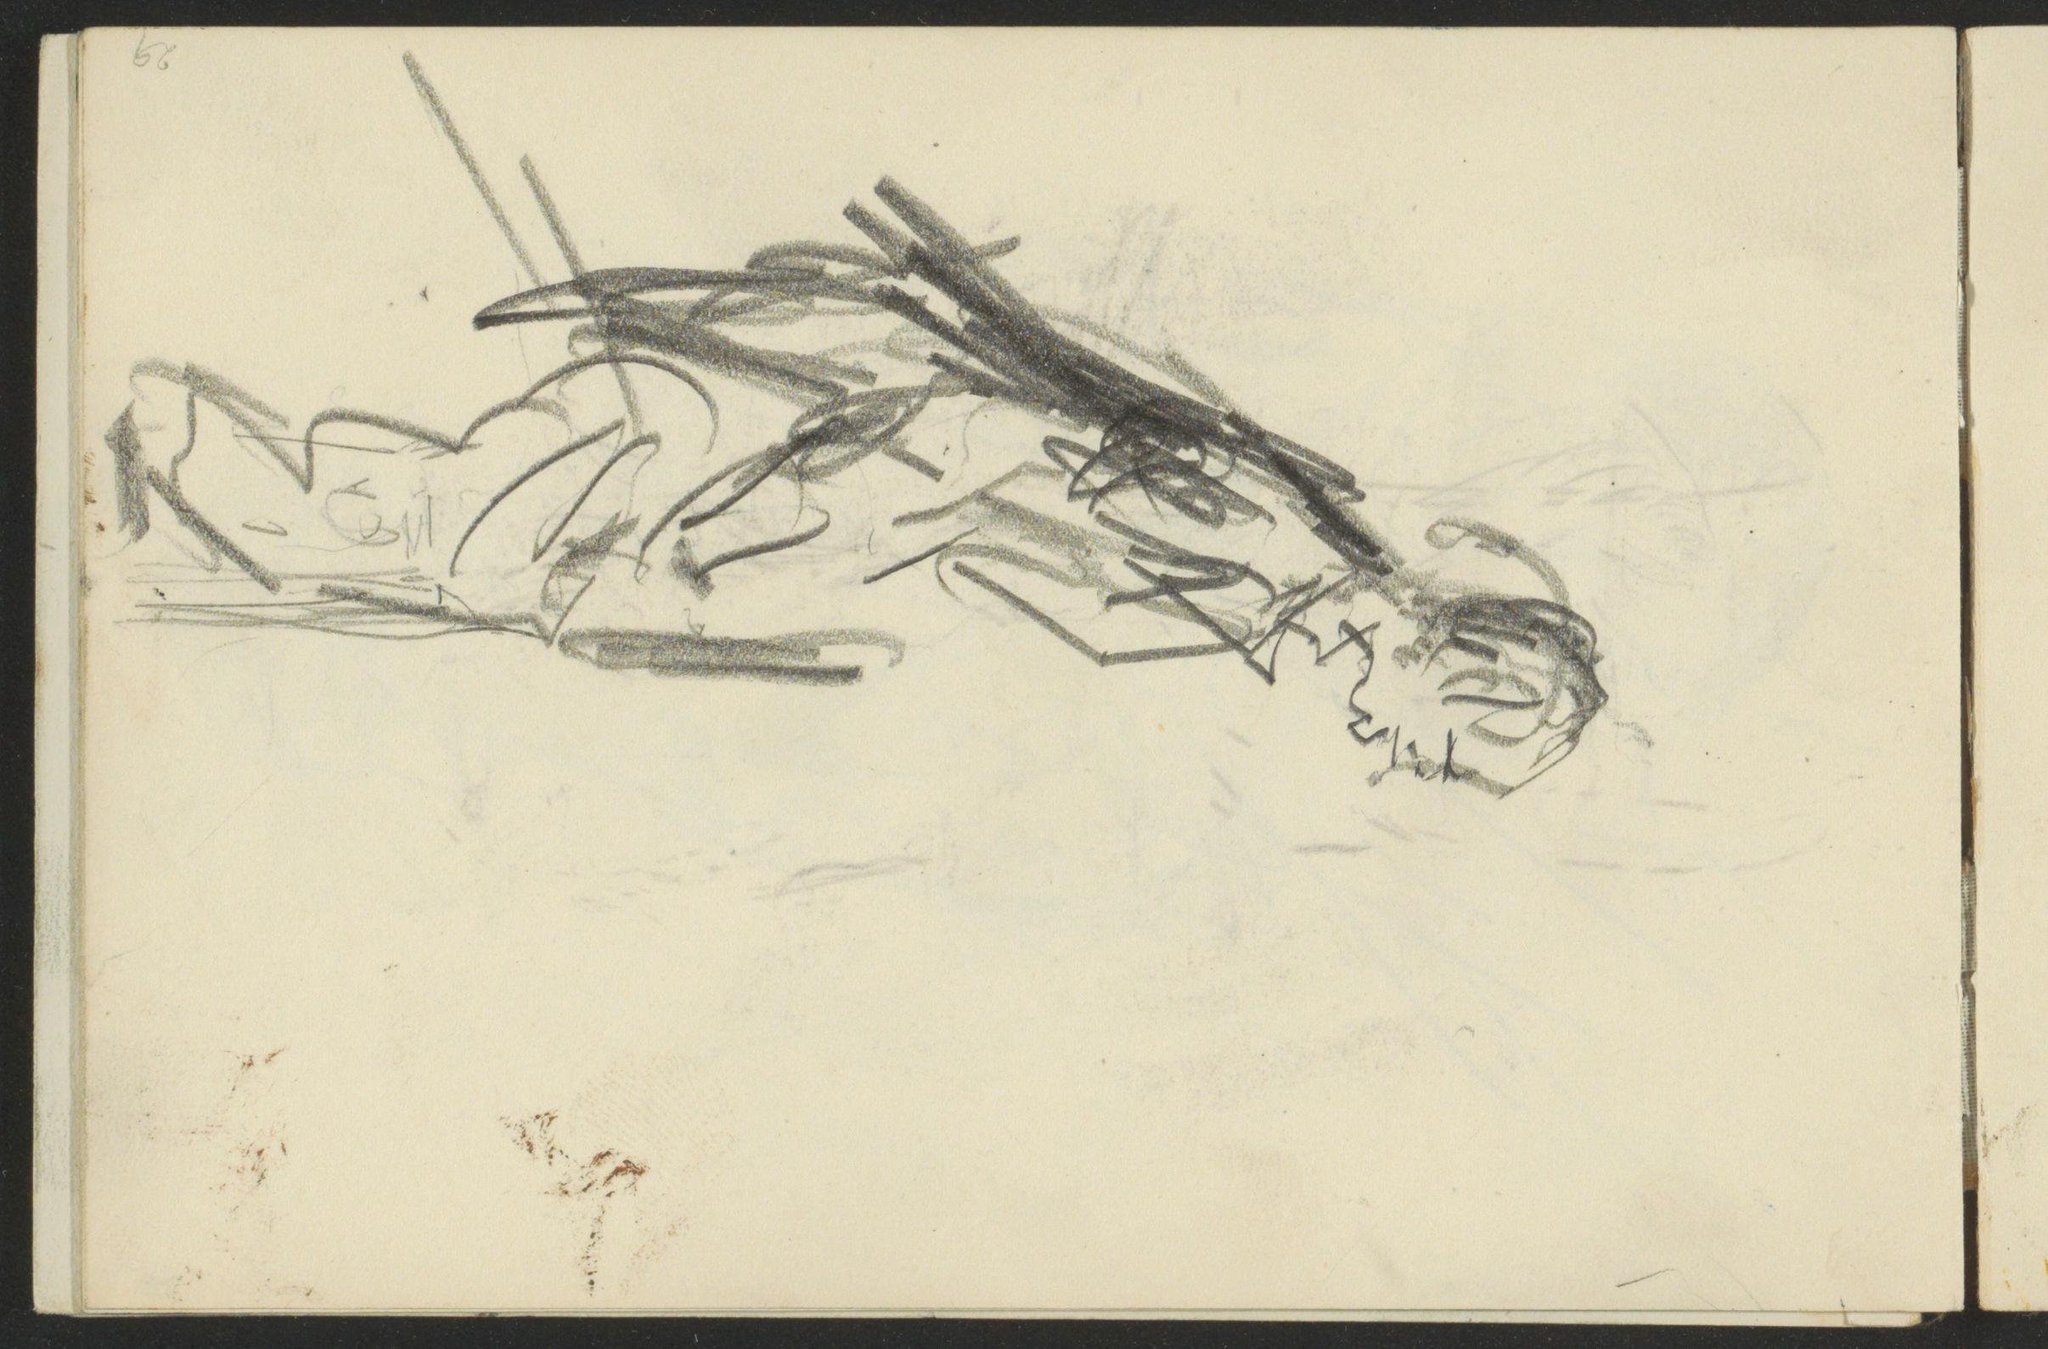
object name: sketchbook leaf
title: Staande man in jacquet, in profiel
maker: isaac israels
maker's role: draughtsman, painter, print maker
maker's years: 1865-1934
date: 1875-1934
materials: paper, pencil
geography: the hague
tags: adult man (+ standing)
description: Hij buigt licht voorover. Blad 12 verso uit schetsboek LXI met 20 bladen.